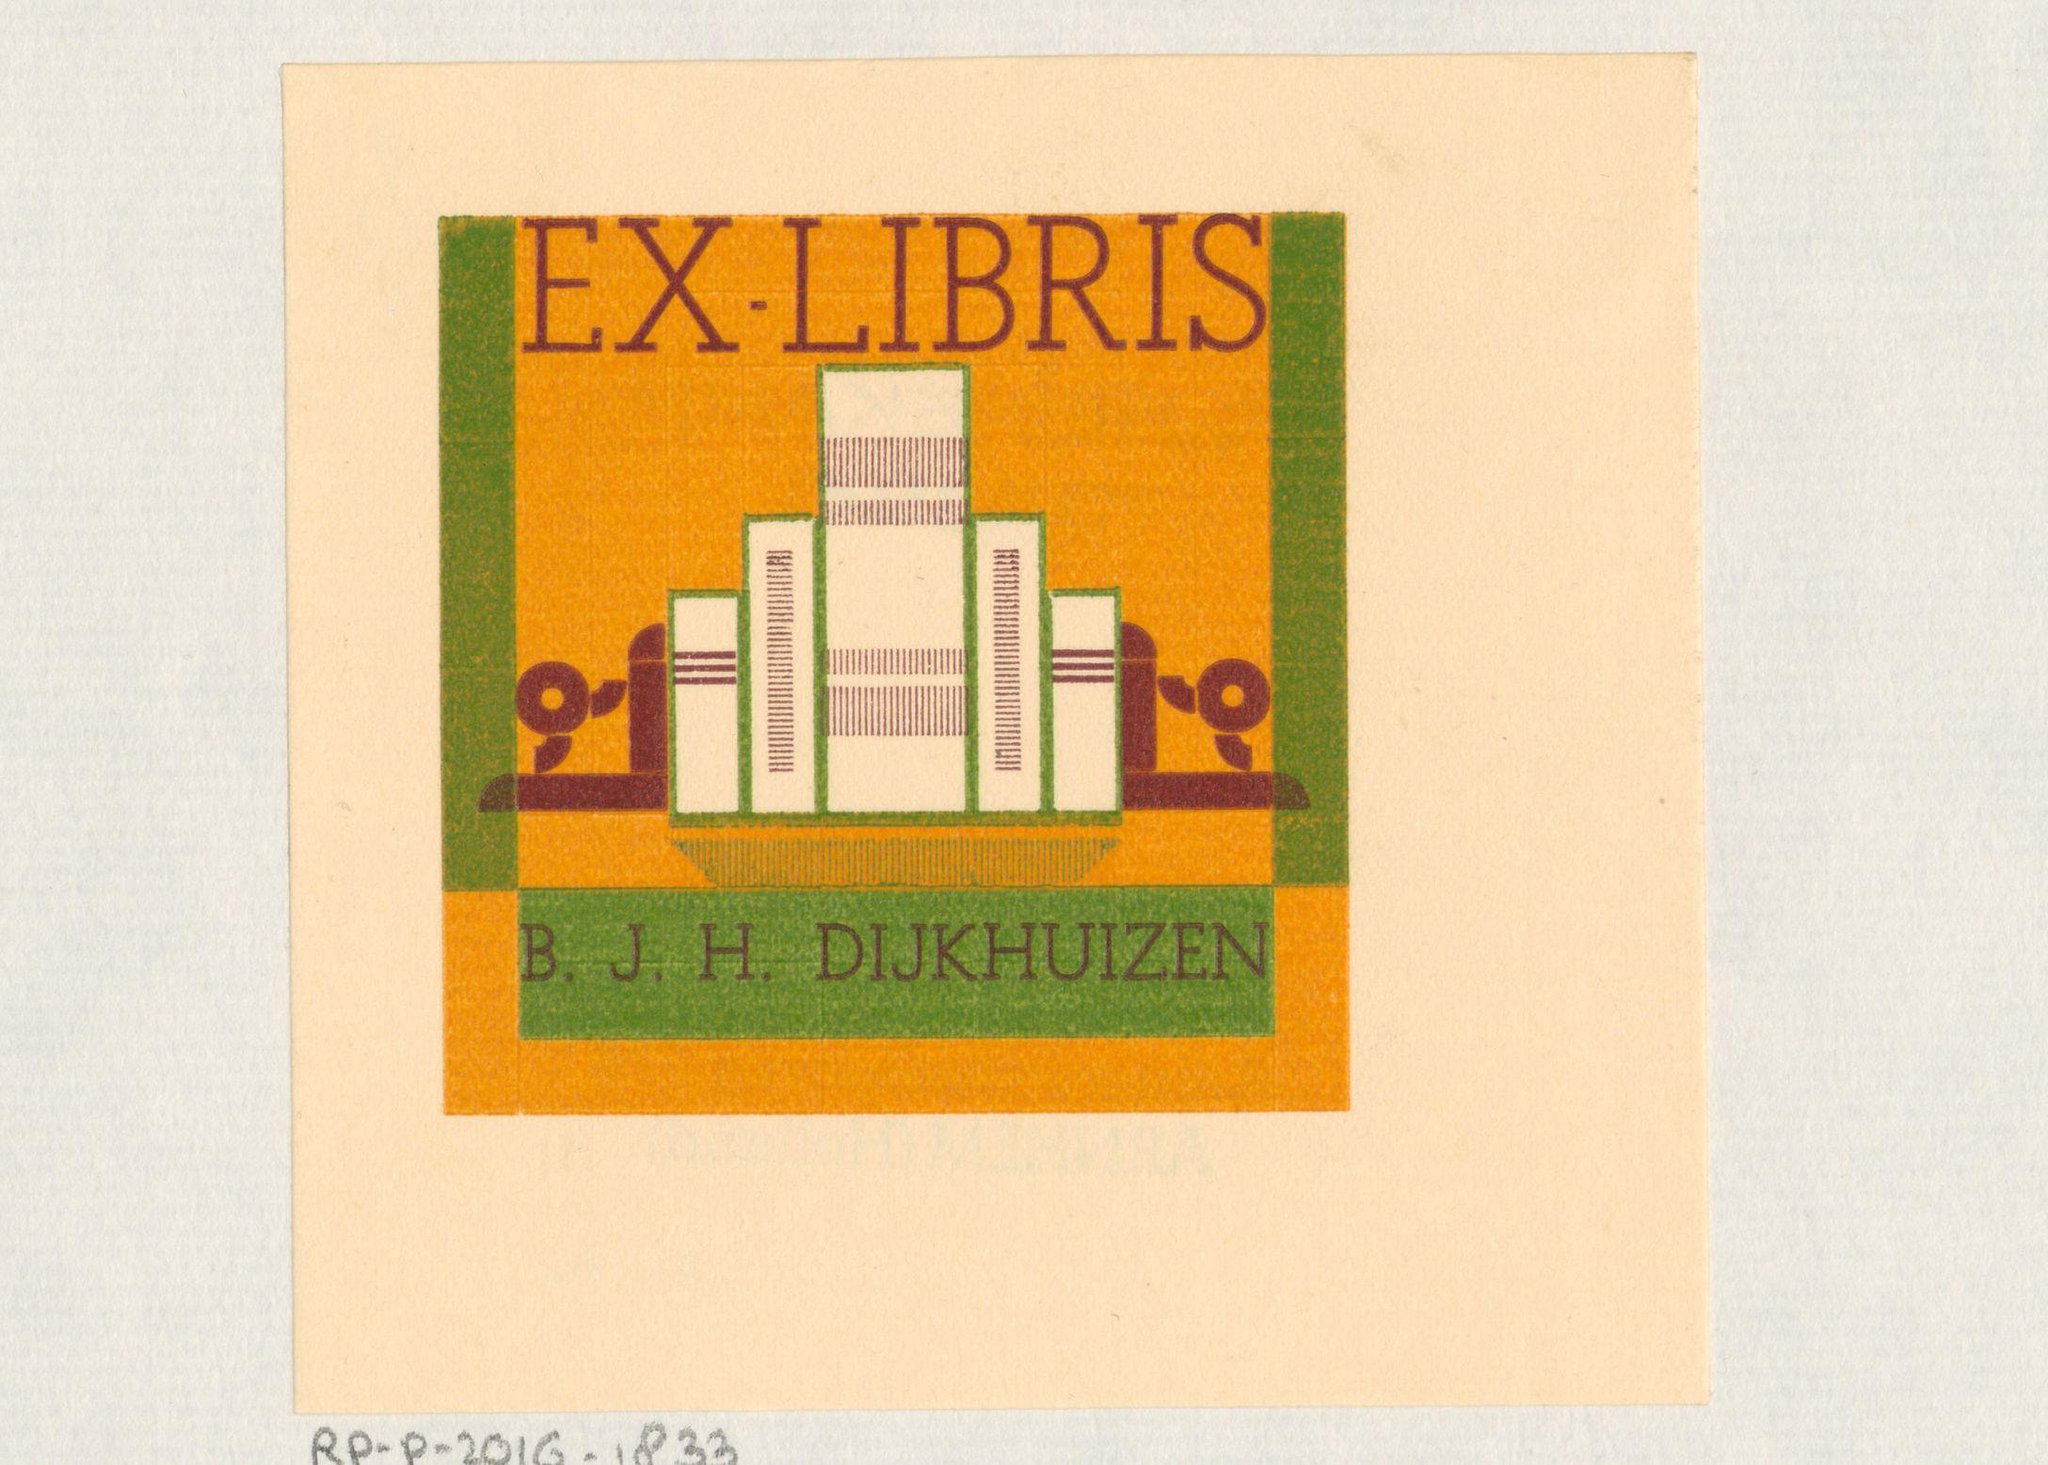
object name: bookplate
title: Ex libris van B.J.H. Dijkhuizen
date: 1941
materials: paper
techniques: printing block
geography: netherlands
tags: b.j.h. dijkhuizen, bookshelves, book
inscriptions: workshop stamp: ‘F. Heinekamp / "T" 1941’, workshop stamp: ‘B.J.H. Dijkhuizen / Amsterdamscheweg 178 / Arnhem (Holland)’